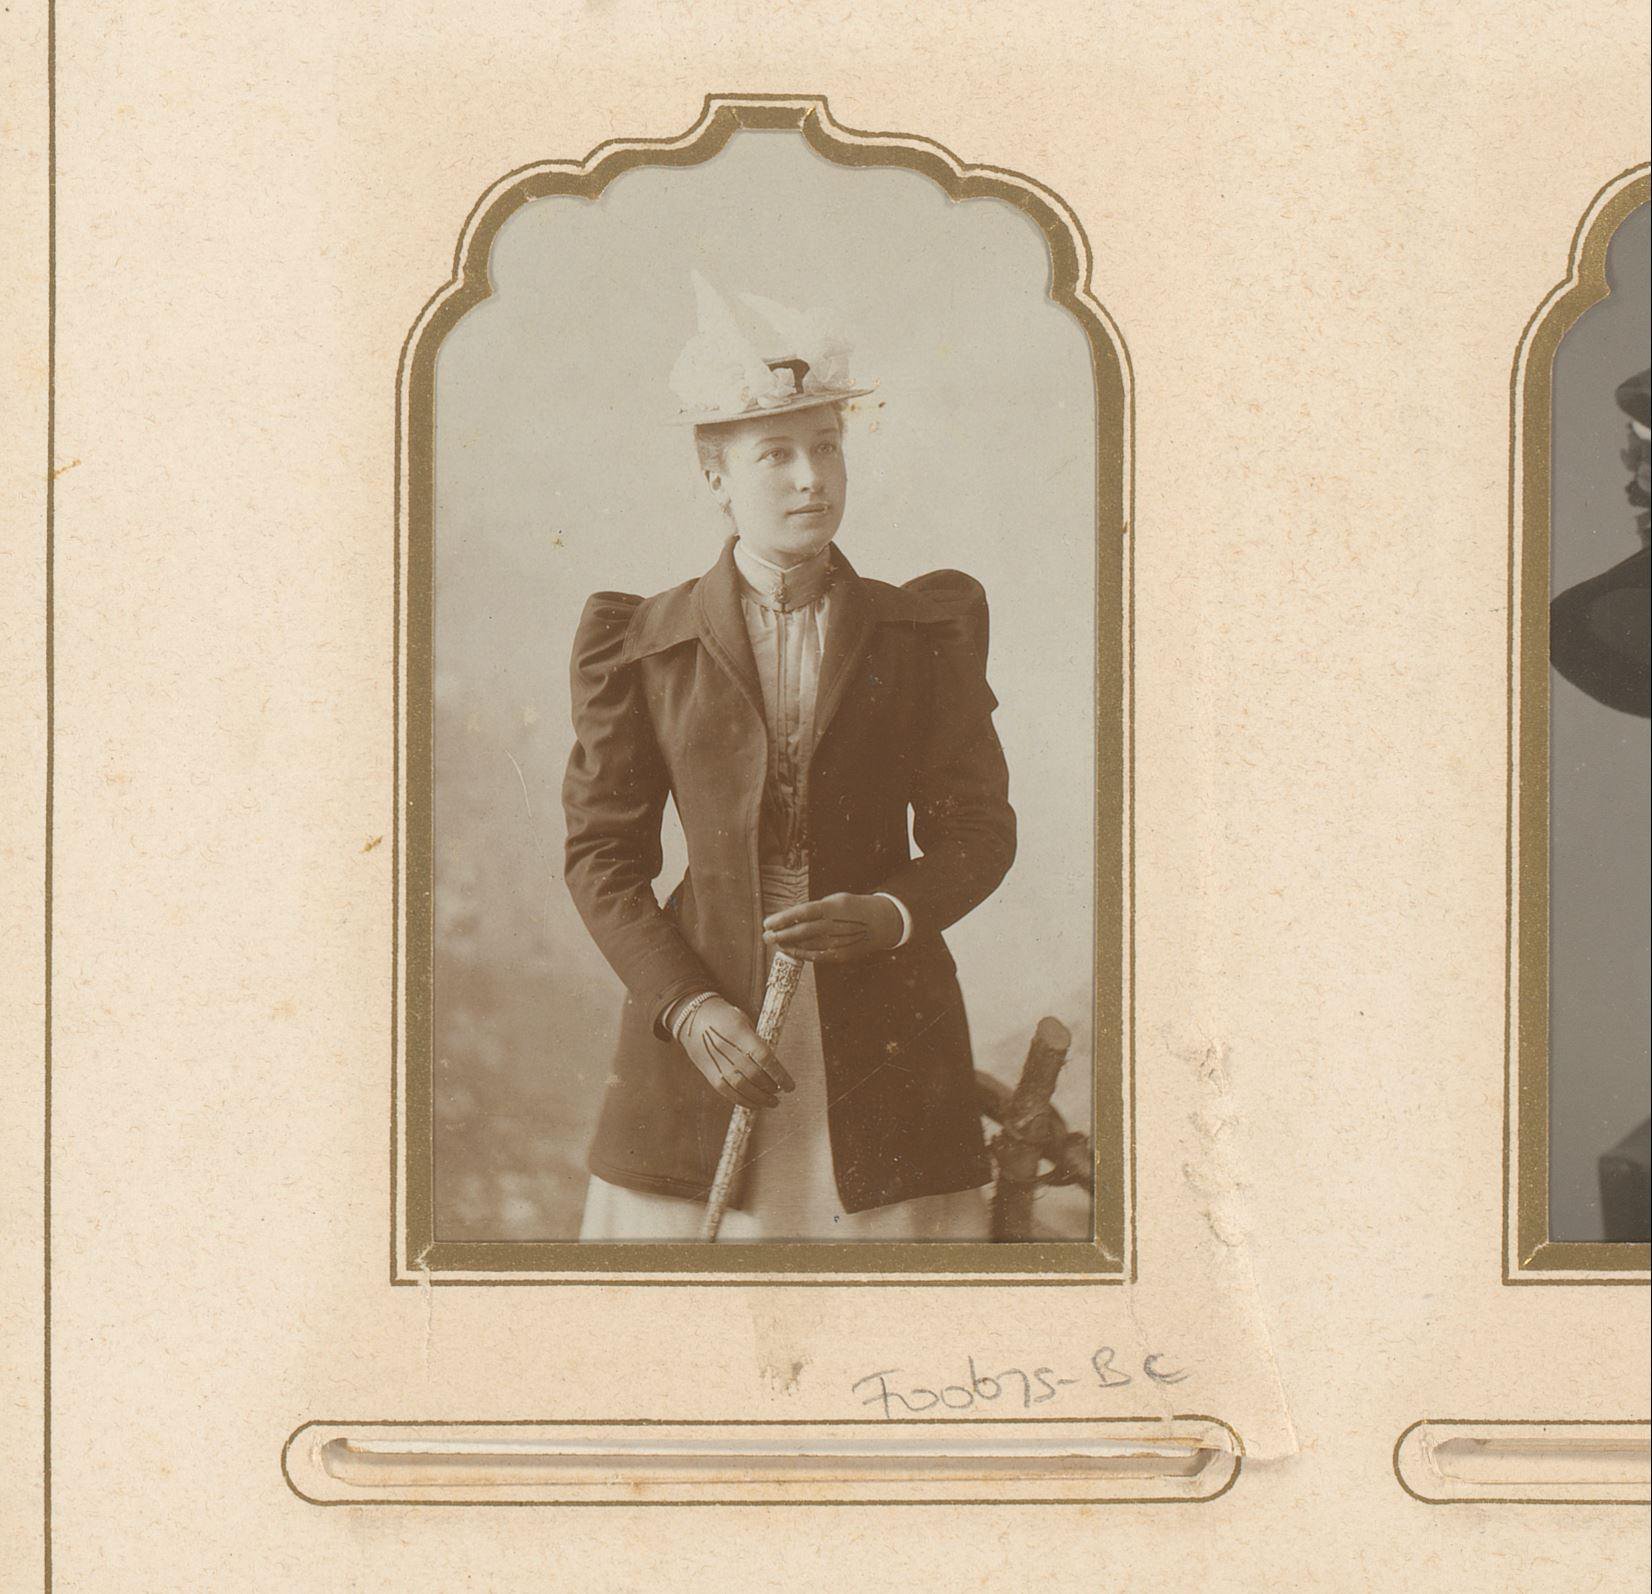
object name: carte de visite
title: Portret van een staande vrouw met paraplu en hoed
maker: albert greiner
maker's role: fotograaf, fotostudio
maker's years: 1833-1890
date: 1861-1874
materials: cardboard, photographic support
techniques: collodion silver print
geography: amsterdam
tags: historical persons - bb - woman, umbrella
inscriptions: inscription: ‘Albert Greiner/ Amsterdam/ Nieuwendijk 89’